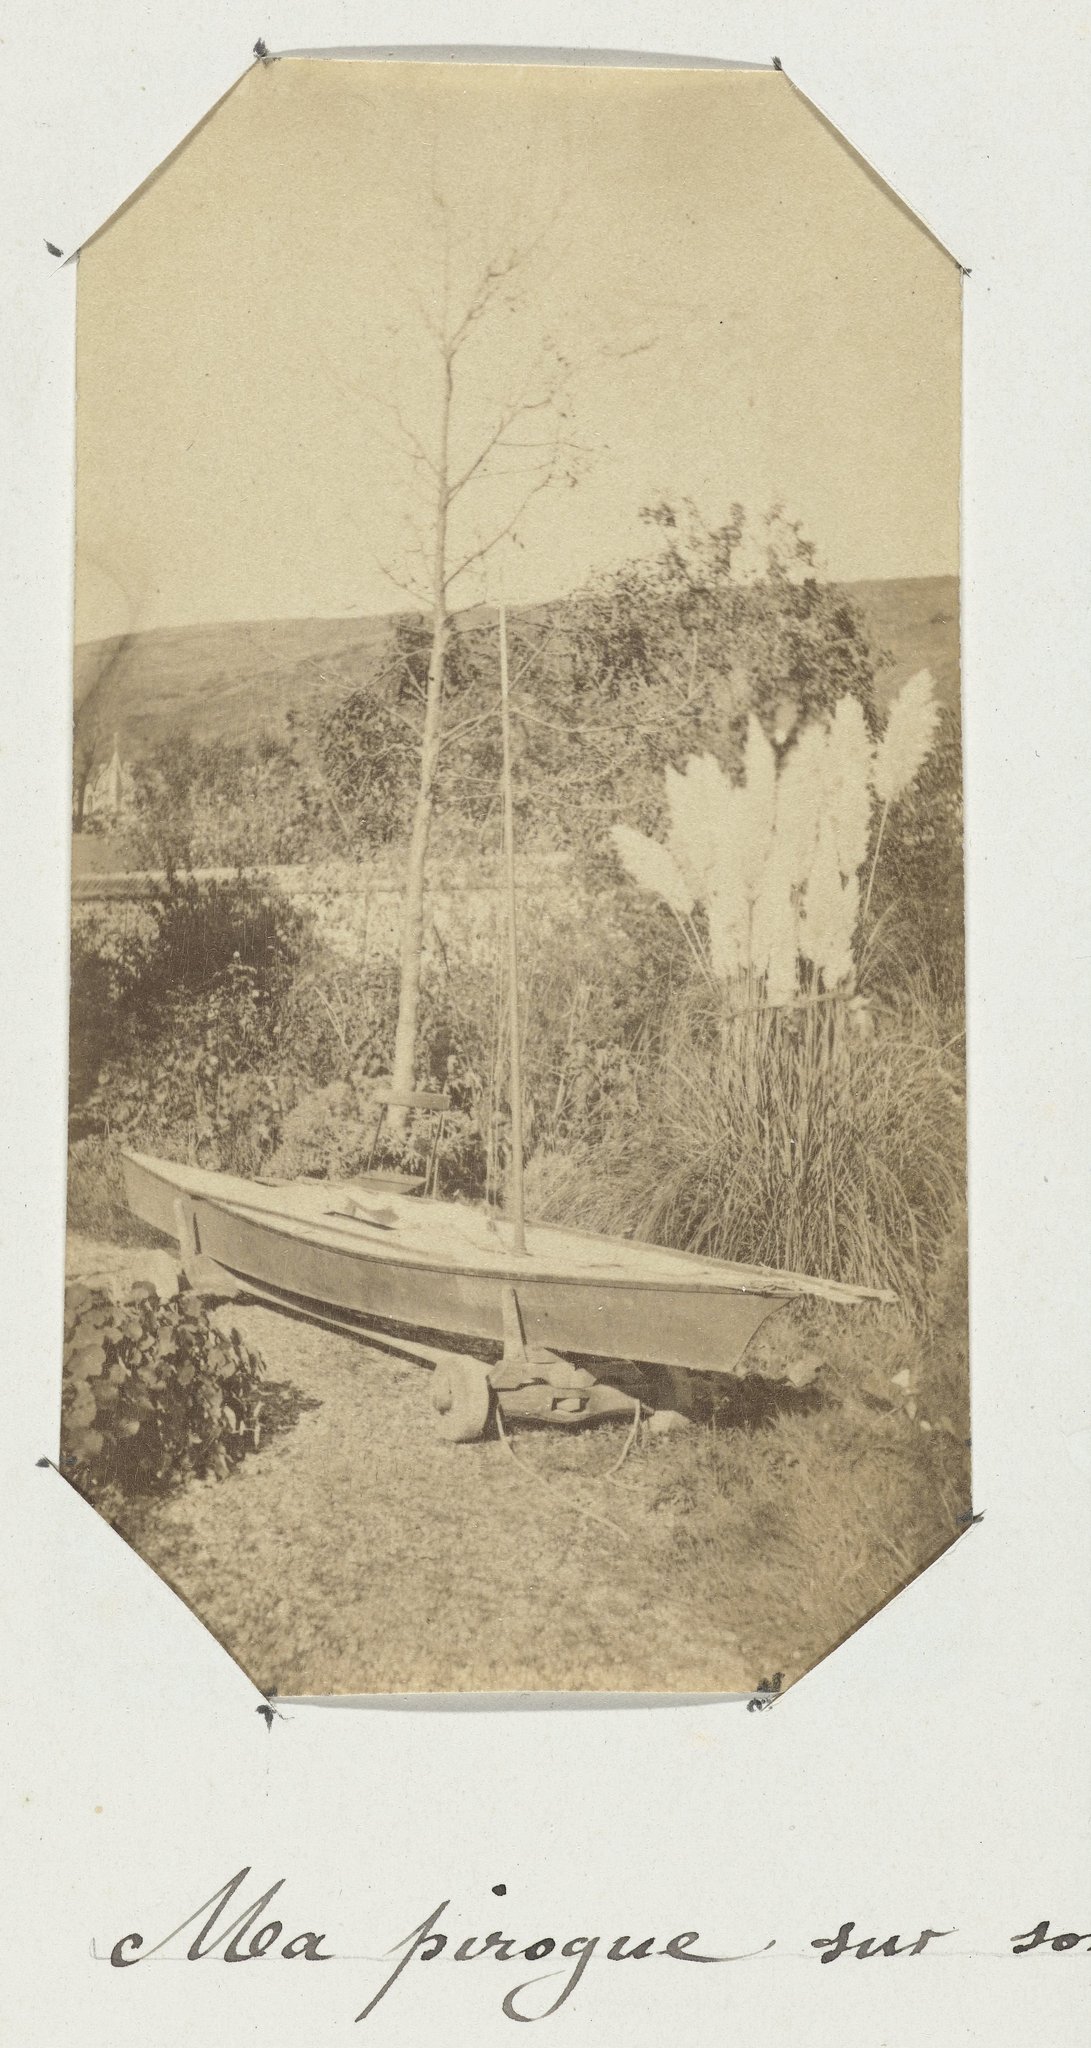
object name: photograph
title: Ma pirogue sur son chariot de transport (1871-1876)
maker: Anonymous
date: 1876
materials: paper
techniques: albumen print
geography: les petites-dalles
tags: sailing-ship, sailing-boat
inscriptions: inscription: ‘Ma pirogue sur son chariot de transport (1871-1876)’, inscription: ‘1876’